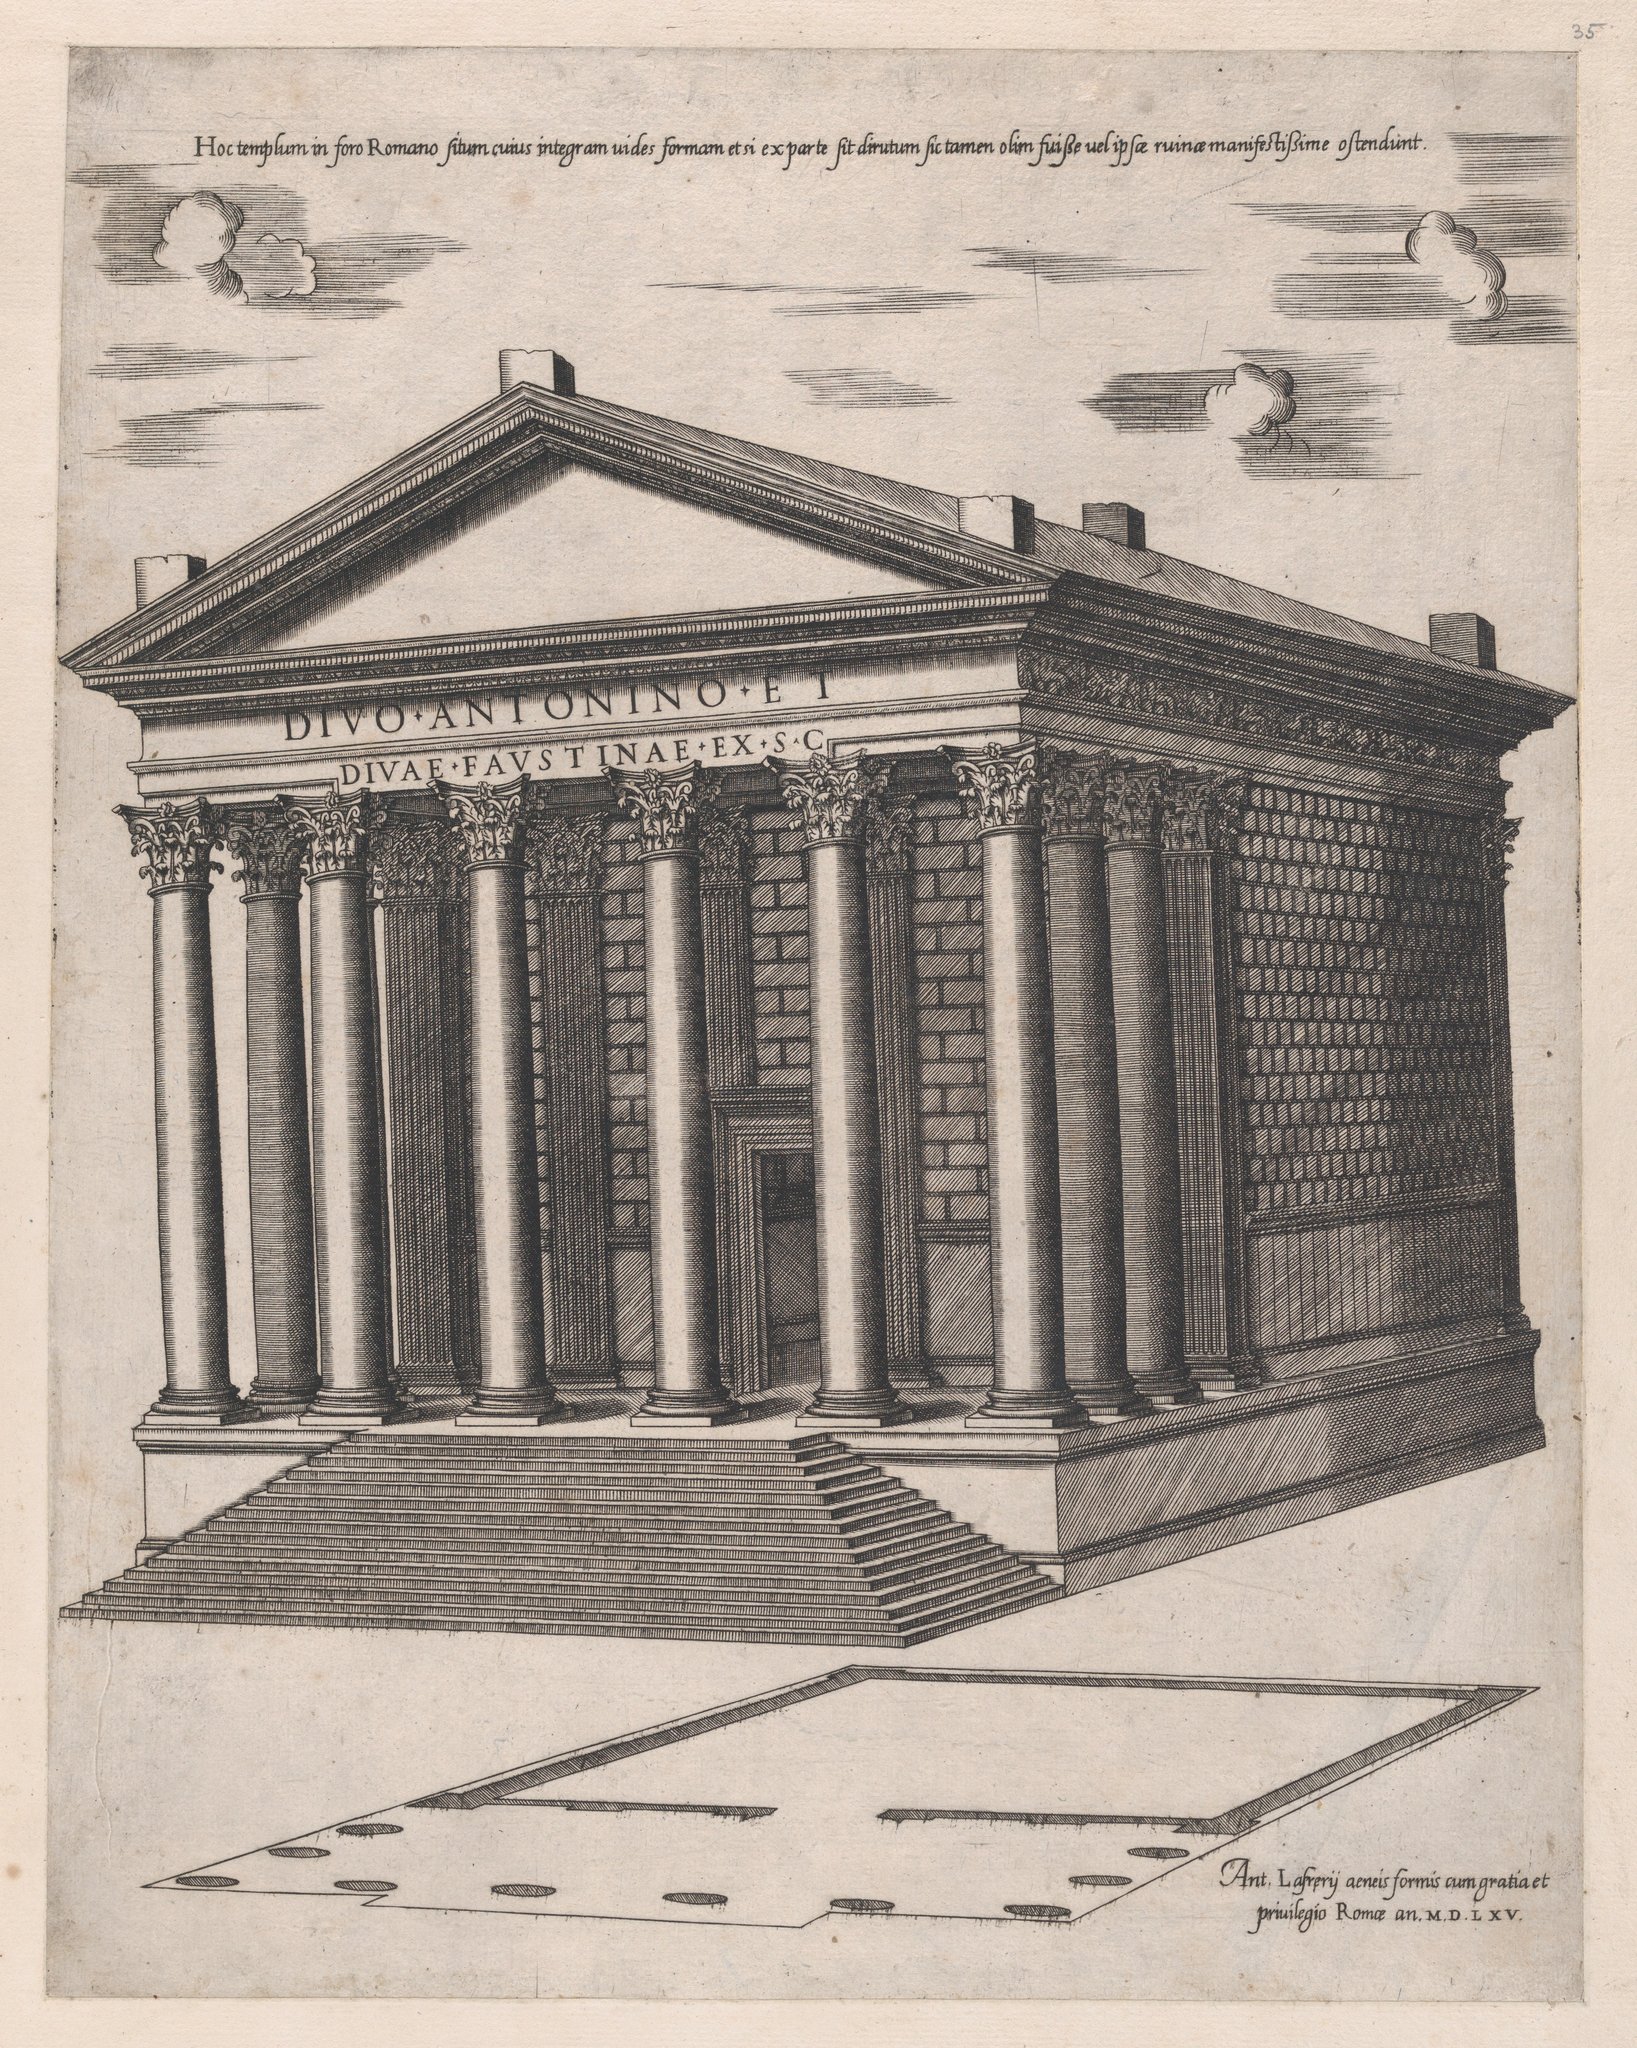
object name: print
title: Temple of Antoninus and Faustina, from "Speculum Romanae Magnificentiae"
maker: Anonymous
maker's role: artist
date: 1565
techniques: engraving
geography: rome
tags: architecture,temples,rome